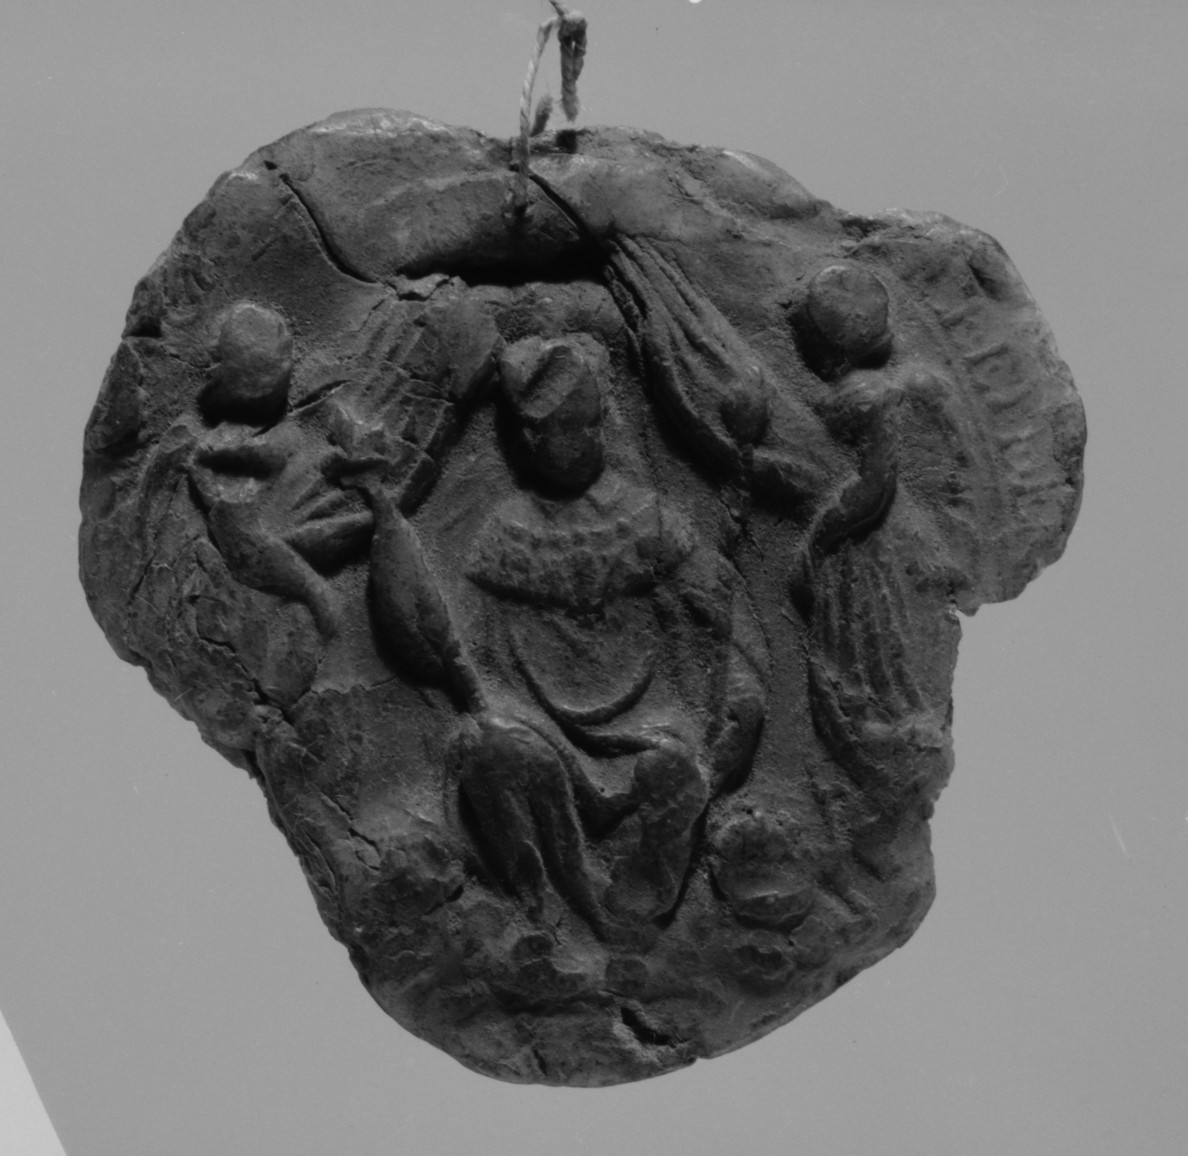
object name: wax impression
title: Seal of Louis XIV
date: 1701-1800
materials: wax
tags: louis xiv